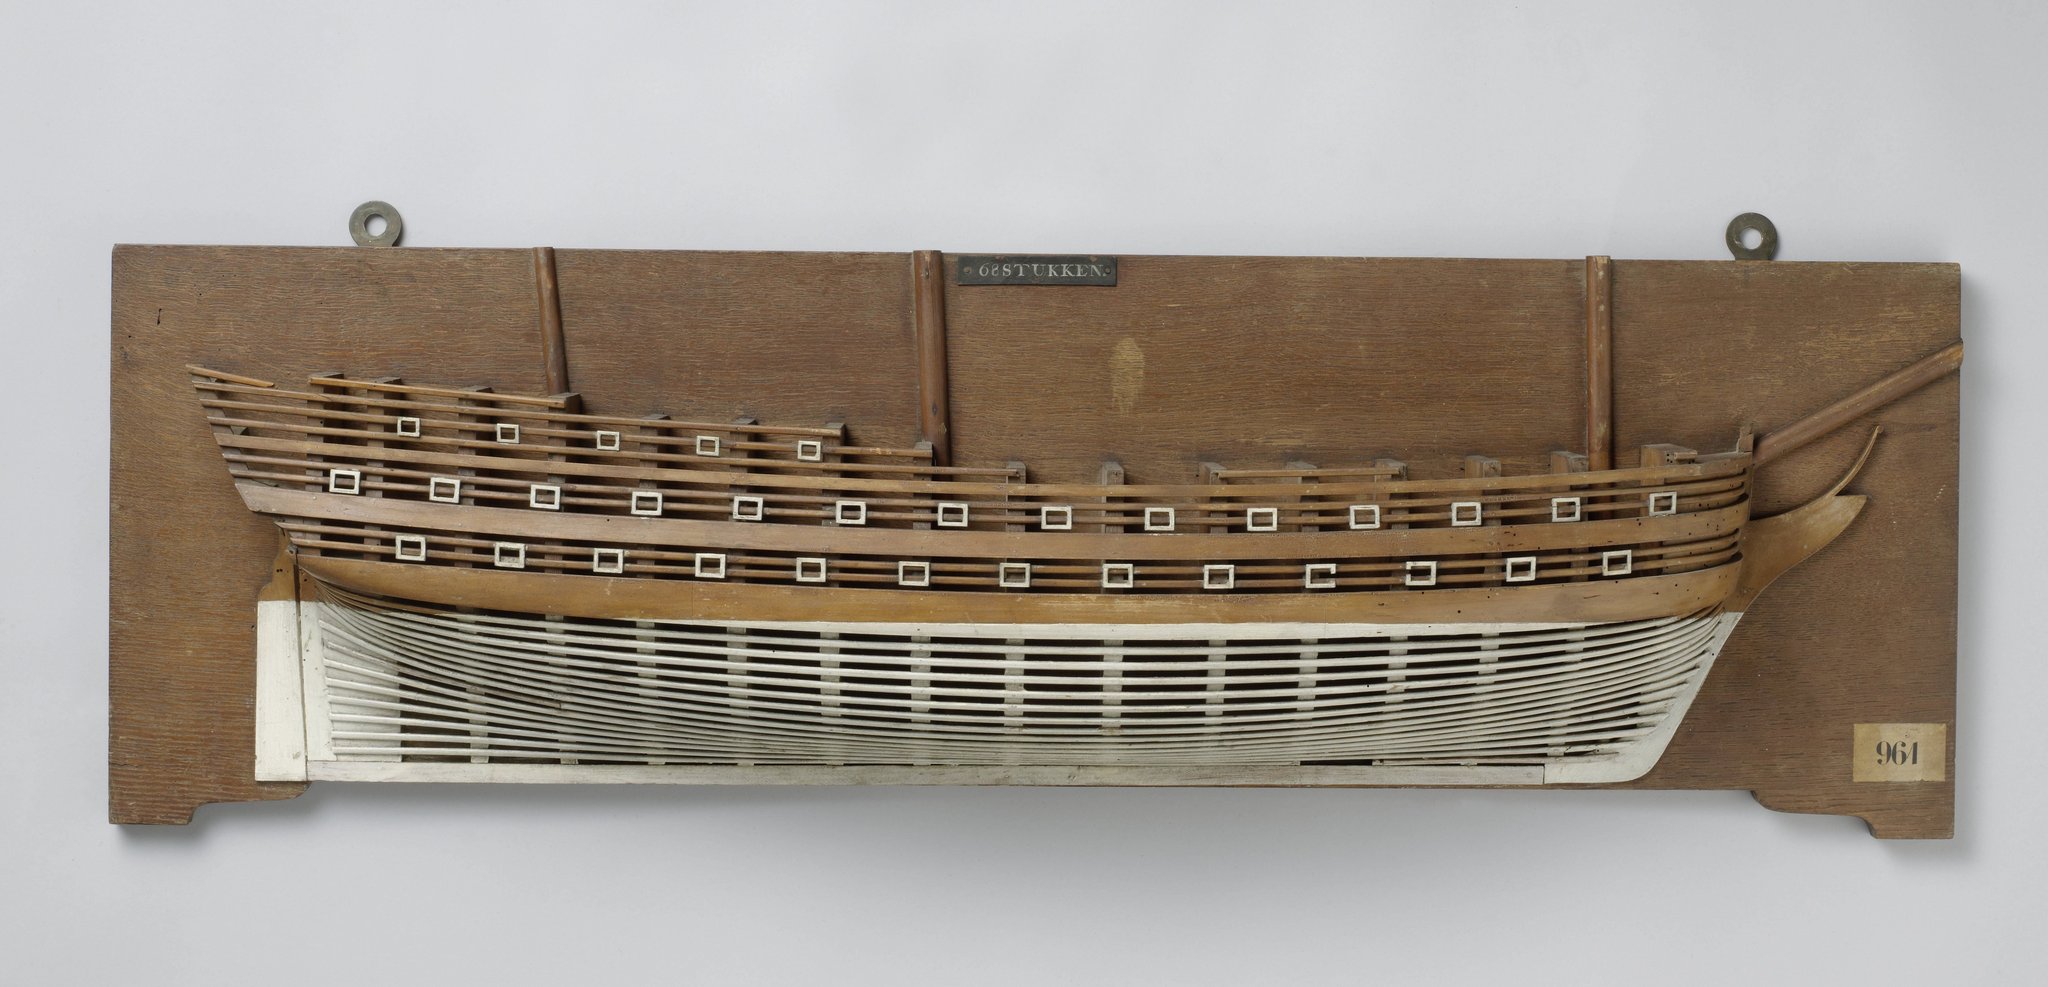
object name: ship model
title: Half Model of a 68-Gun Ship of the Line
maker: Anonymous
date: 1750-1820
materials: wood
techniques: polychromy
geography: netherlands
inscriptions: label, bottom right: ‘961’ former inventory label, inscription, top centre, on a rectangular black label: ‘68 STUKKEN.’